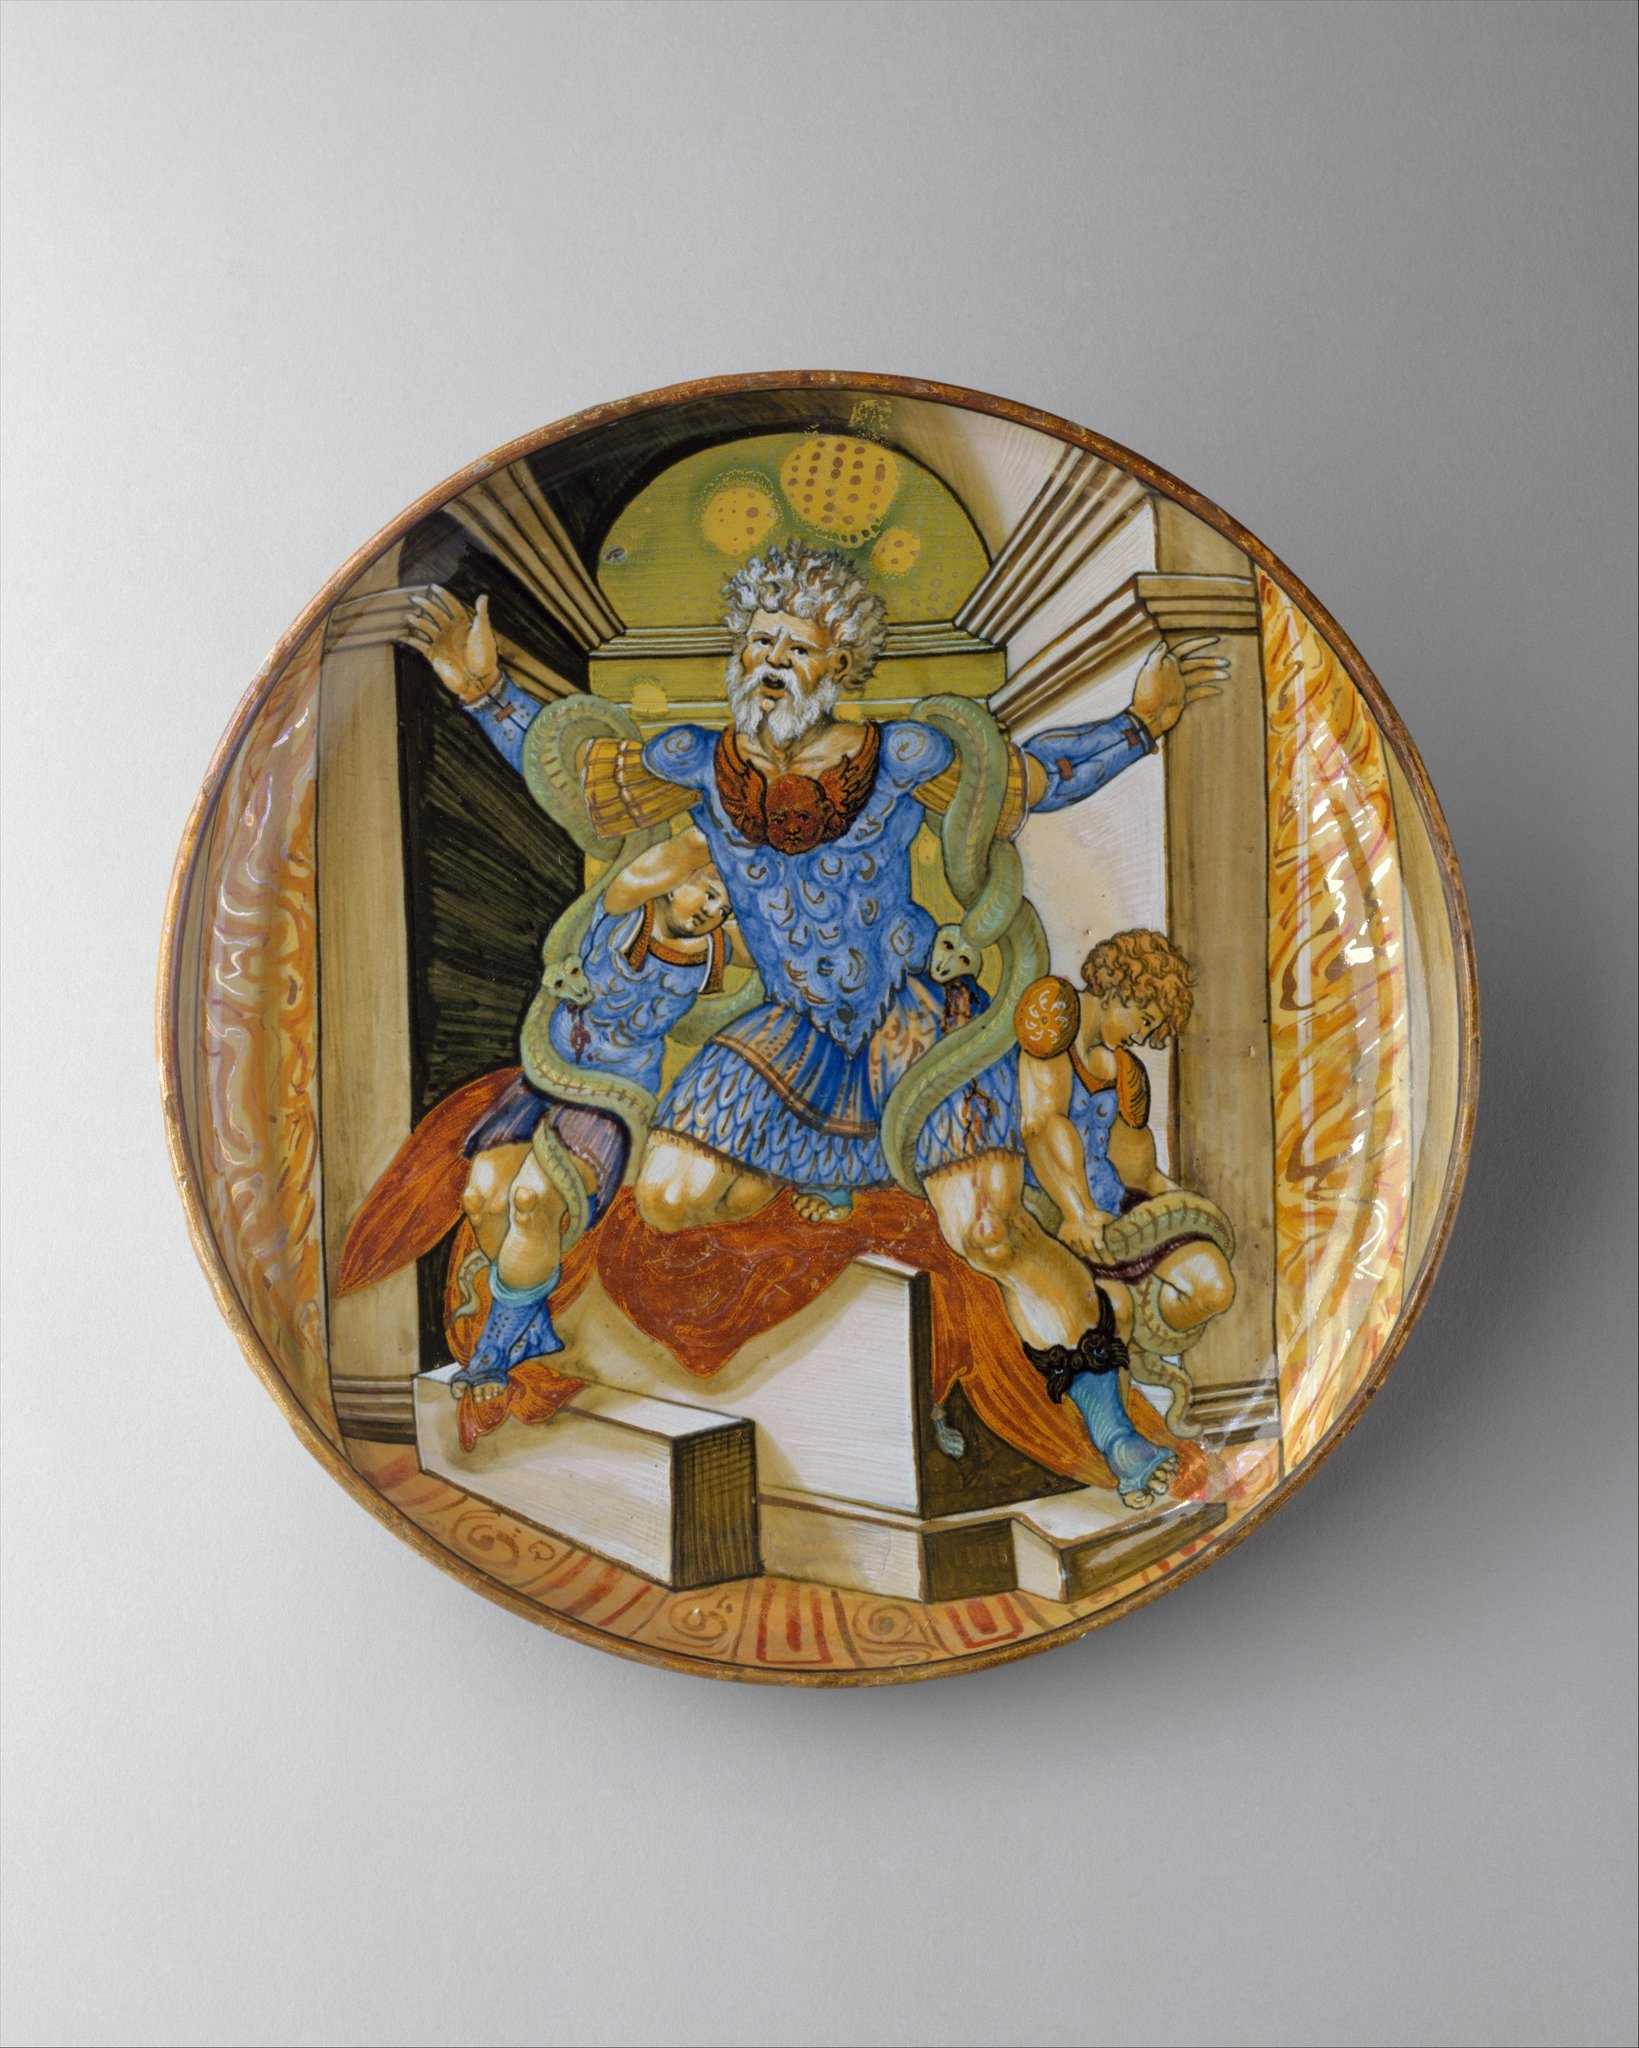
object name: dish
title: Dish (coppa)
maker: francesco xanto avelli da rovigo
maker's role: artist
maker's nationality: italian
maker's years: 1482-1542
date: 1532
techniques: maiolica, glazing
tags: men,snakes